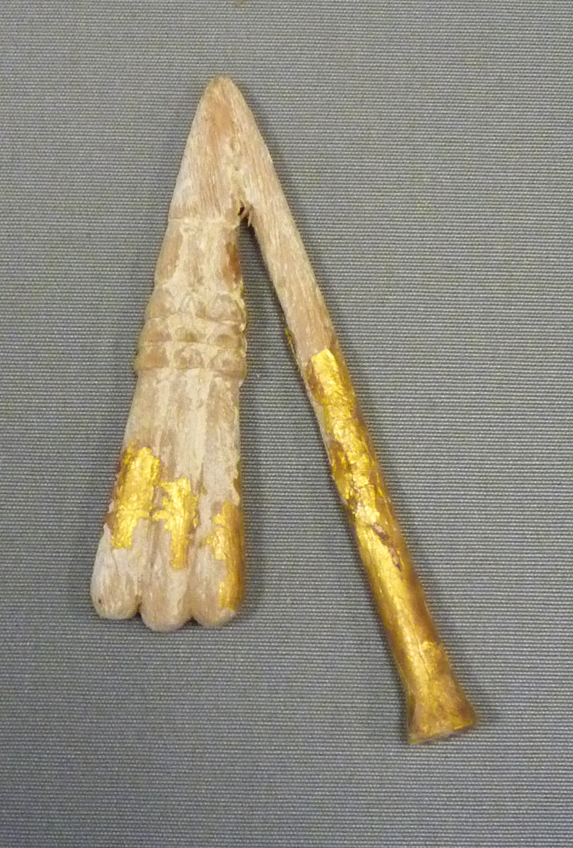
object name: model flail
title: Model Flail from the Foundation Deposit for Hatshepsut's Tomb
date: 1479-1458 BCE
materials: gold foil, wood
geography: egypt